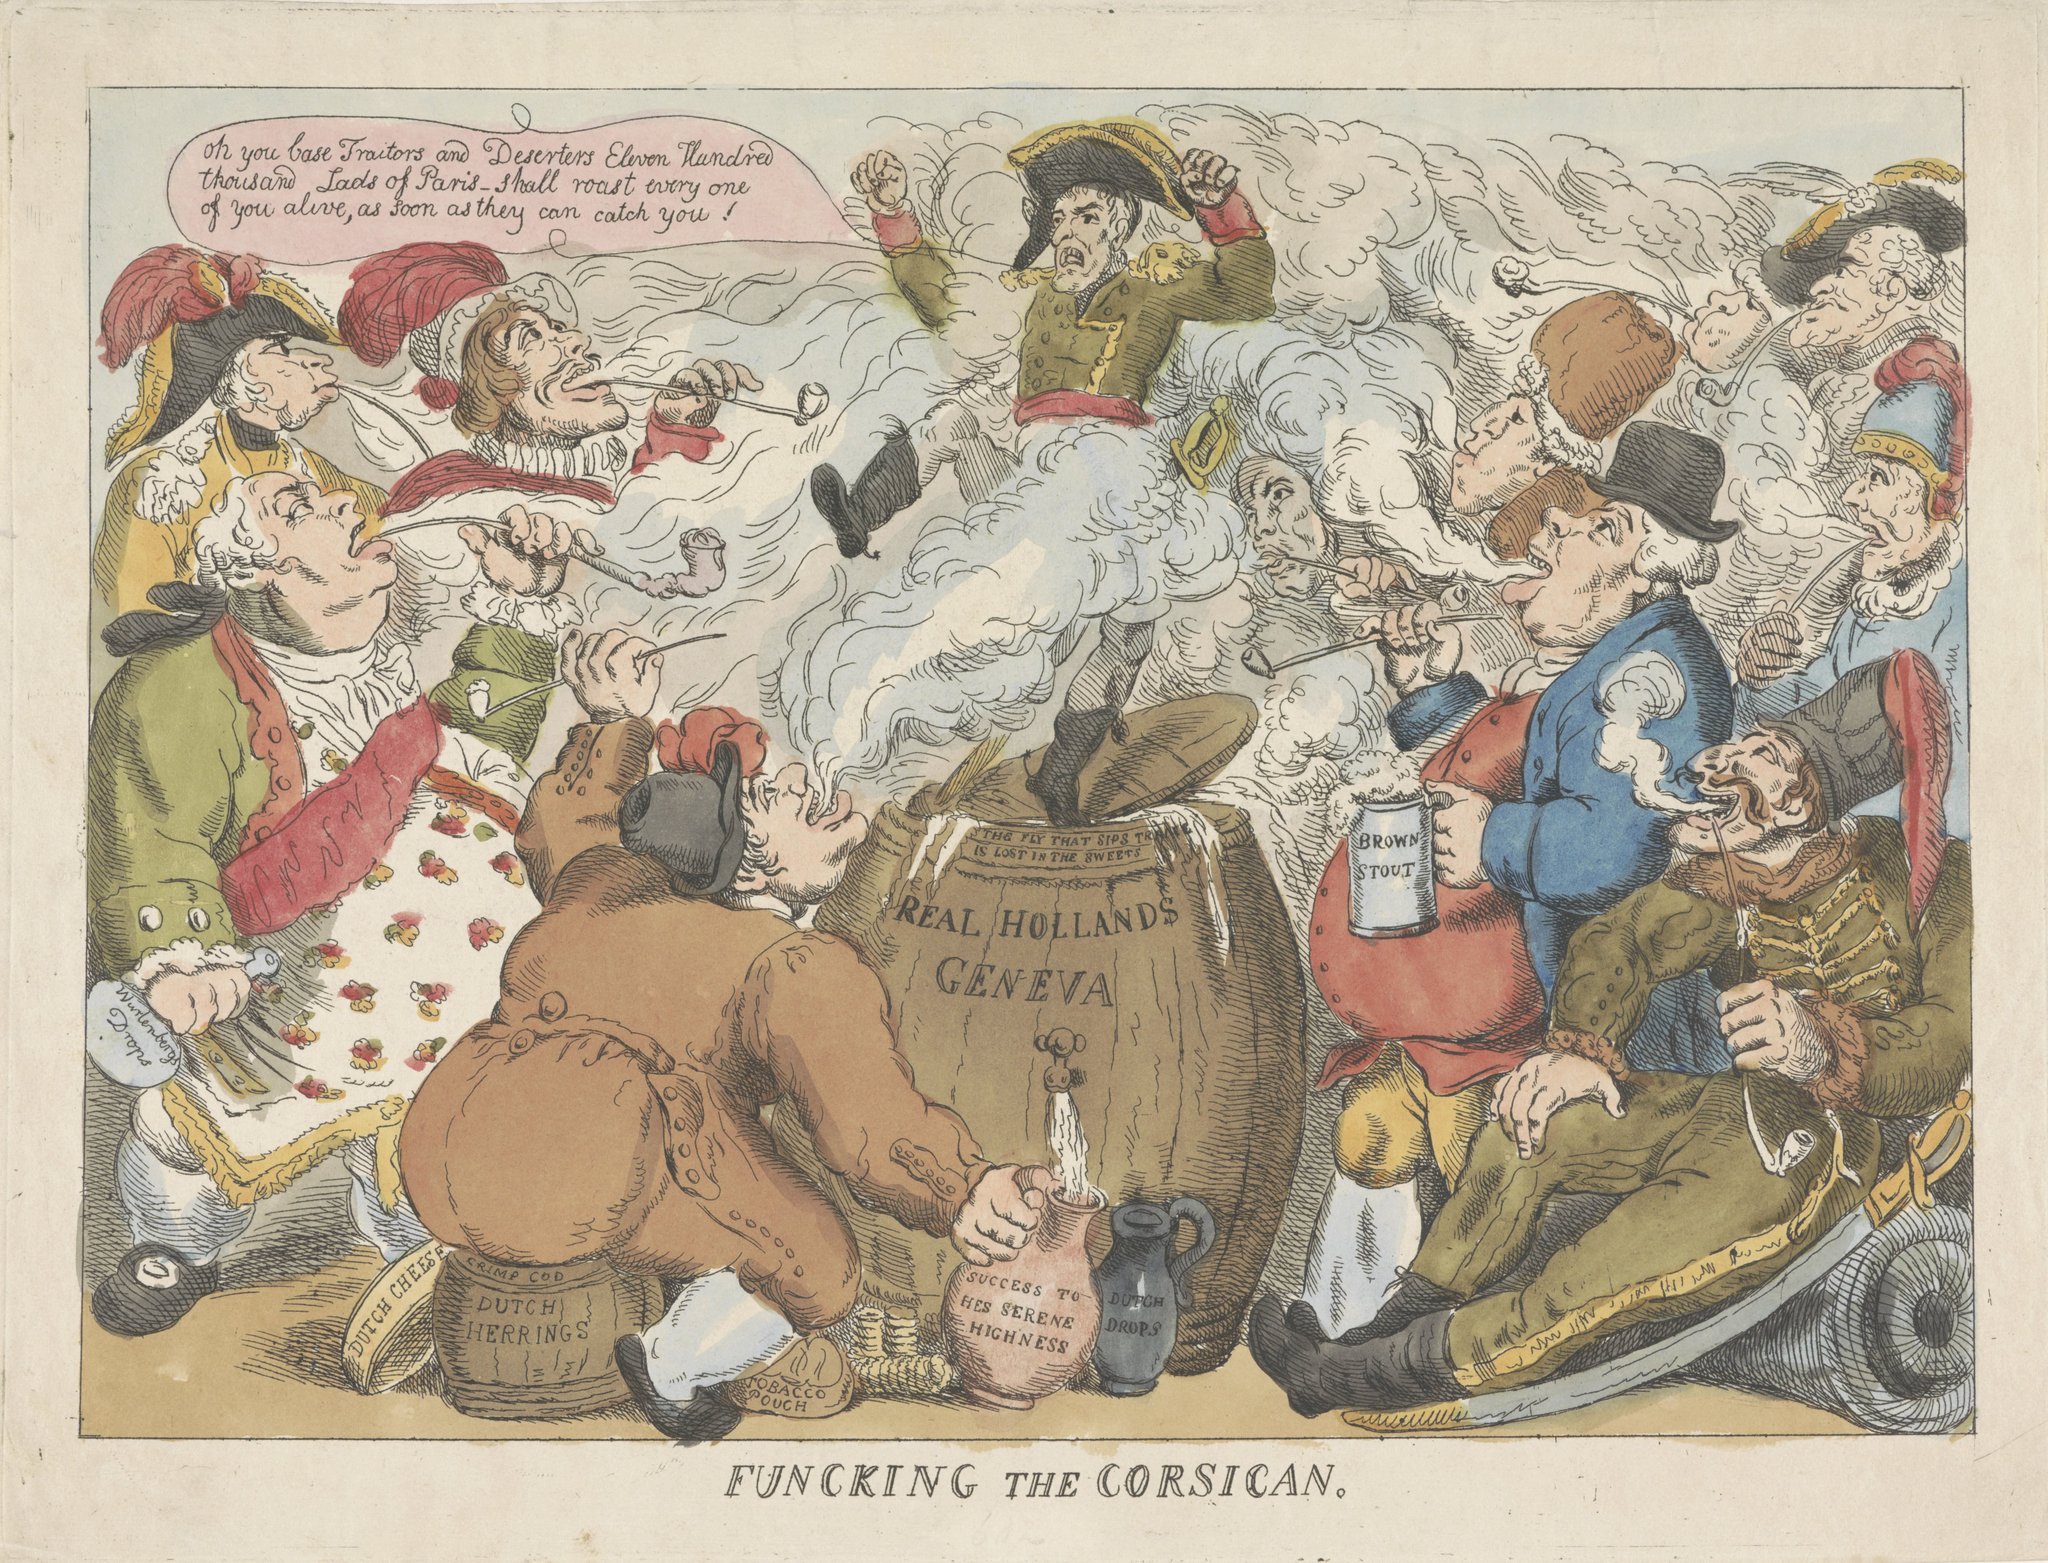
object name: cartoon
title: Funcking the Corsican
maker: Anonymous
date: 1813-1815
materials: paper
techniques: etching, hand coloring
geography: england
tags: napoleon i (emperor of the french), smoke, personifications of countries, nations, states, districts, etc., pipe ~ tobacco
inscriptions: collector's mark: Lugt 2228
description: Spotprent op Napoleon na zijn verlies in de slag bij Leipzig, 1813. Een kleine figuur van Napoleon staat boos te stampvoeten bovenop een grote houten vat met Hollandse jenever waardoor de deksel los raakt. Vertegenwoordigers van verschillende Europese landen roken allen pijp en blazen tabaksrook naar de keizer. Vooraan een dikke Hollander gezeten op een tonnetje haring en een kaas, Rechts de Engelse John Bull, een Pruisische huzaar en anderen. Links de koning van Württemberg, een Oostenrijker en een Spanjaard.